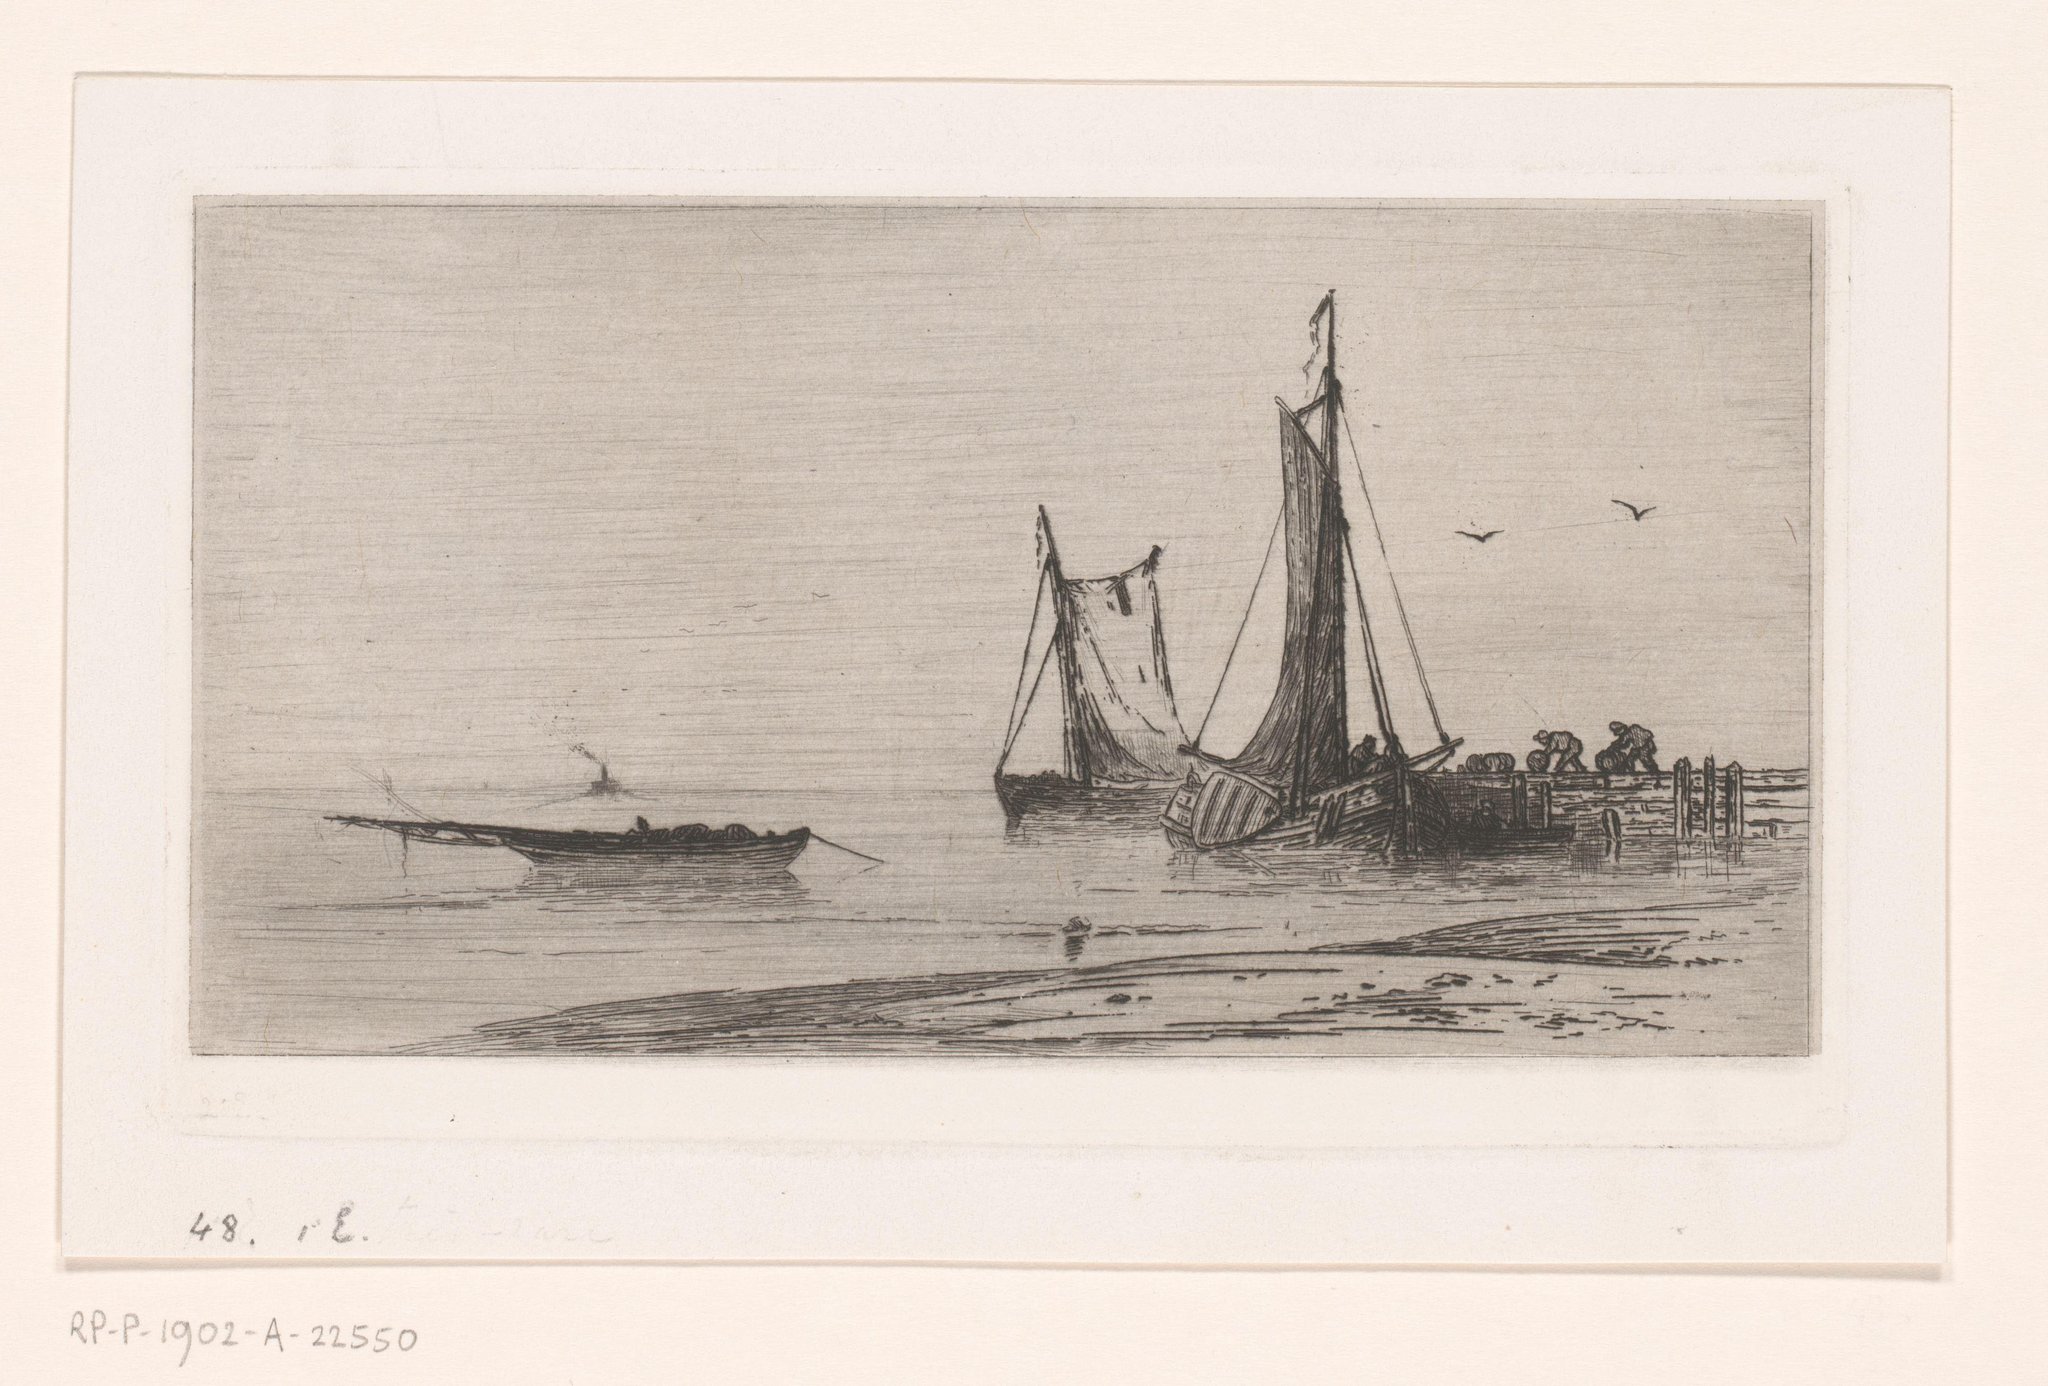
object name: print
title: Souvenir des environs d'Amsterdam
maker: carel nicolaas storm van s-gravesande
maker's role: draughtsman, print maker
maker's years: 1841-1924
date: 1873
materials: paper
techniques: etching, intaglio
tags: sailing-ship, sailing-boat, pier, quay, wharf, amsterdam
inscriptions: collector's mark: Lugt 2228